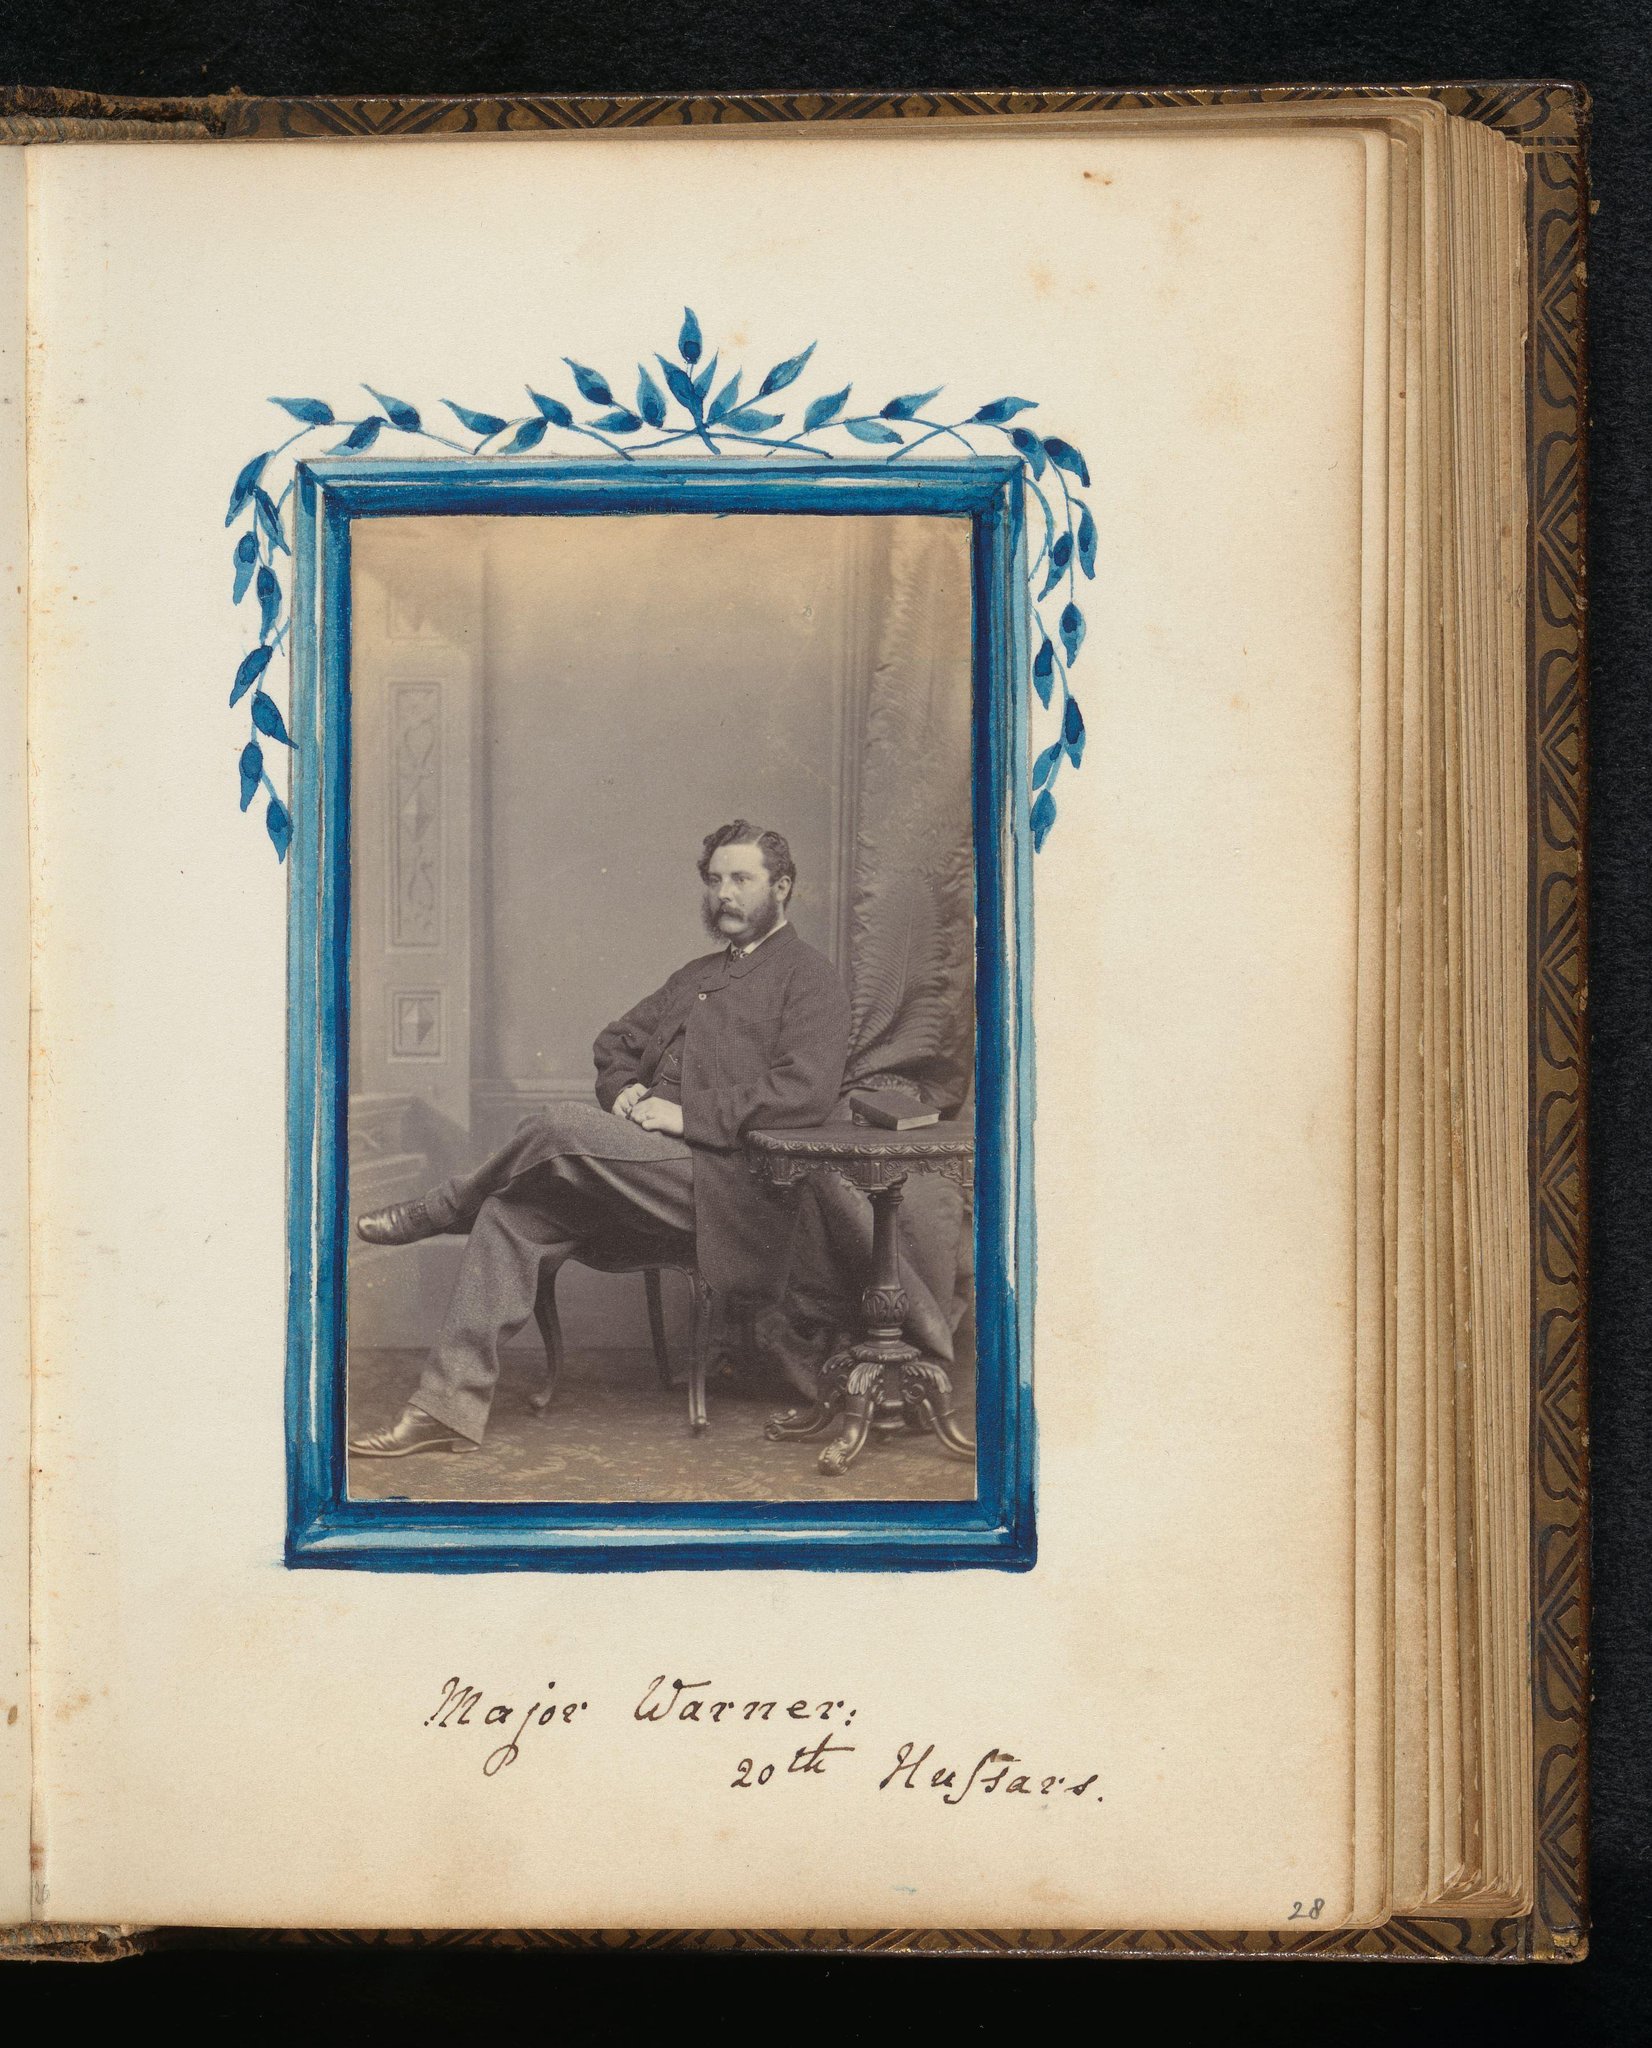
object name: carte de visite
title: Majoor Warner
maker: Anonymous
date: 1865-1867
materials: cardboard, photographic support, watercolor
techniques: albumen print, aquarelle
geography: england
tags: historical persons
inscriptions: annotation: ‘Major Warner: 20th Hussars’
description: Portret van majoor Warner van het 20e regiment huzaren. Foto op albumblad in album met 68 foto's merendeels met geaquarelleerde randversieringen. Het zijn voornamelijk portretten op carte-de-visite formaat.